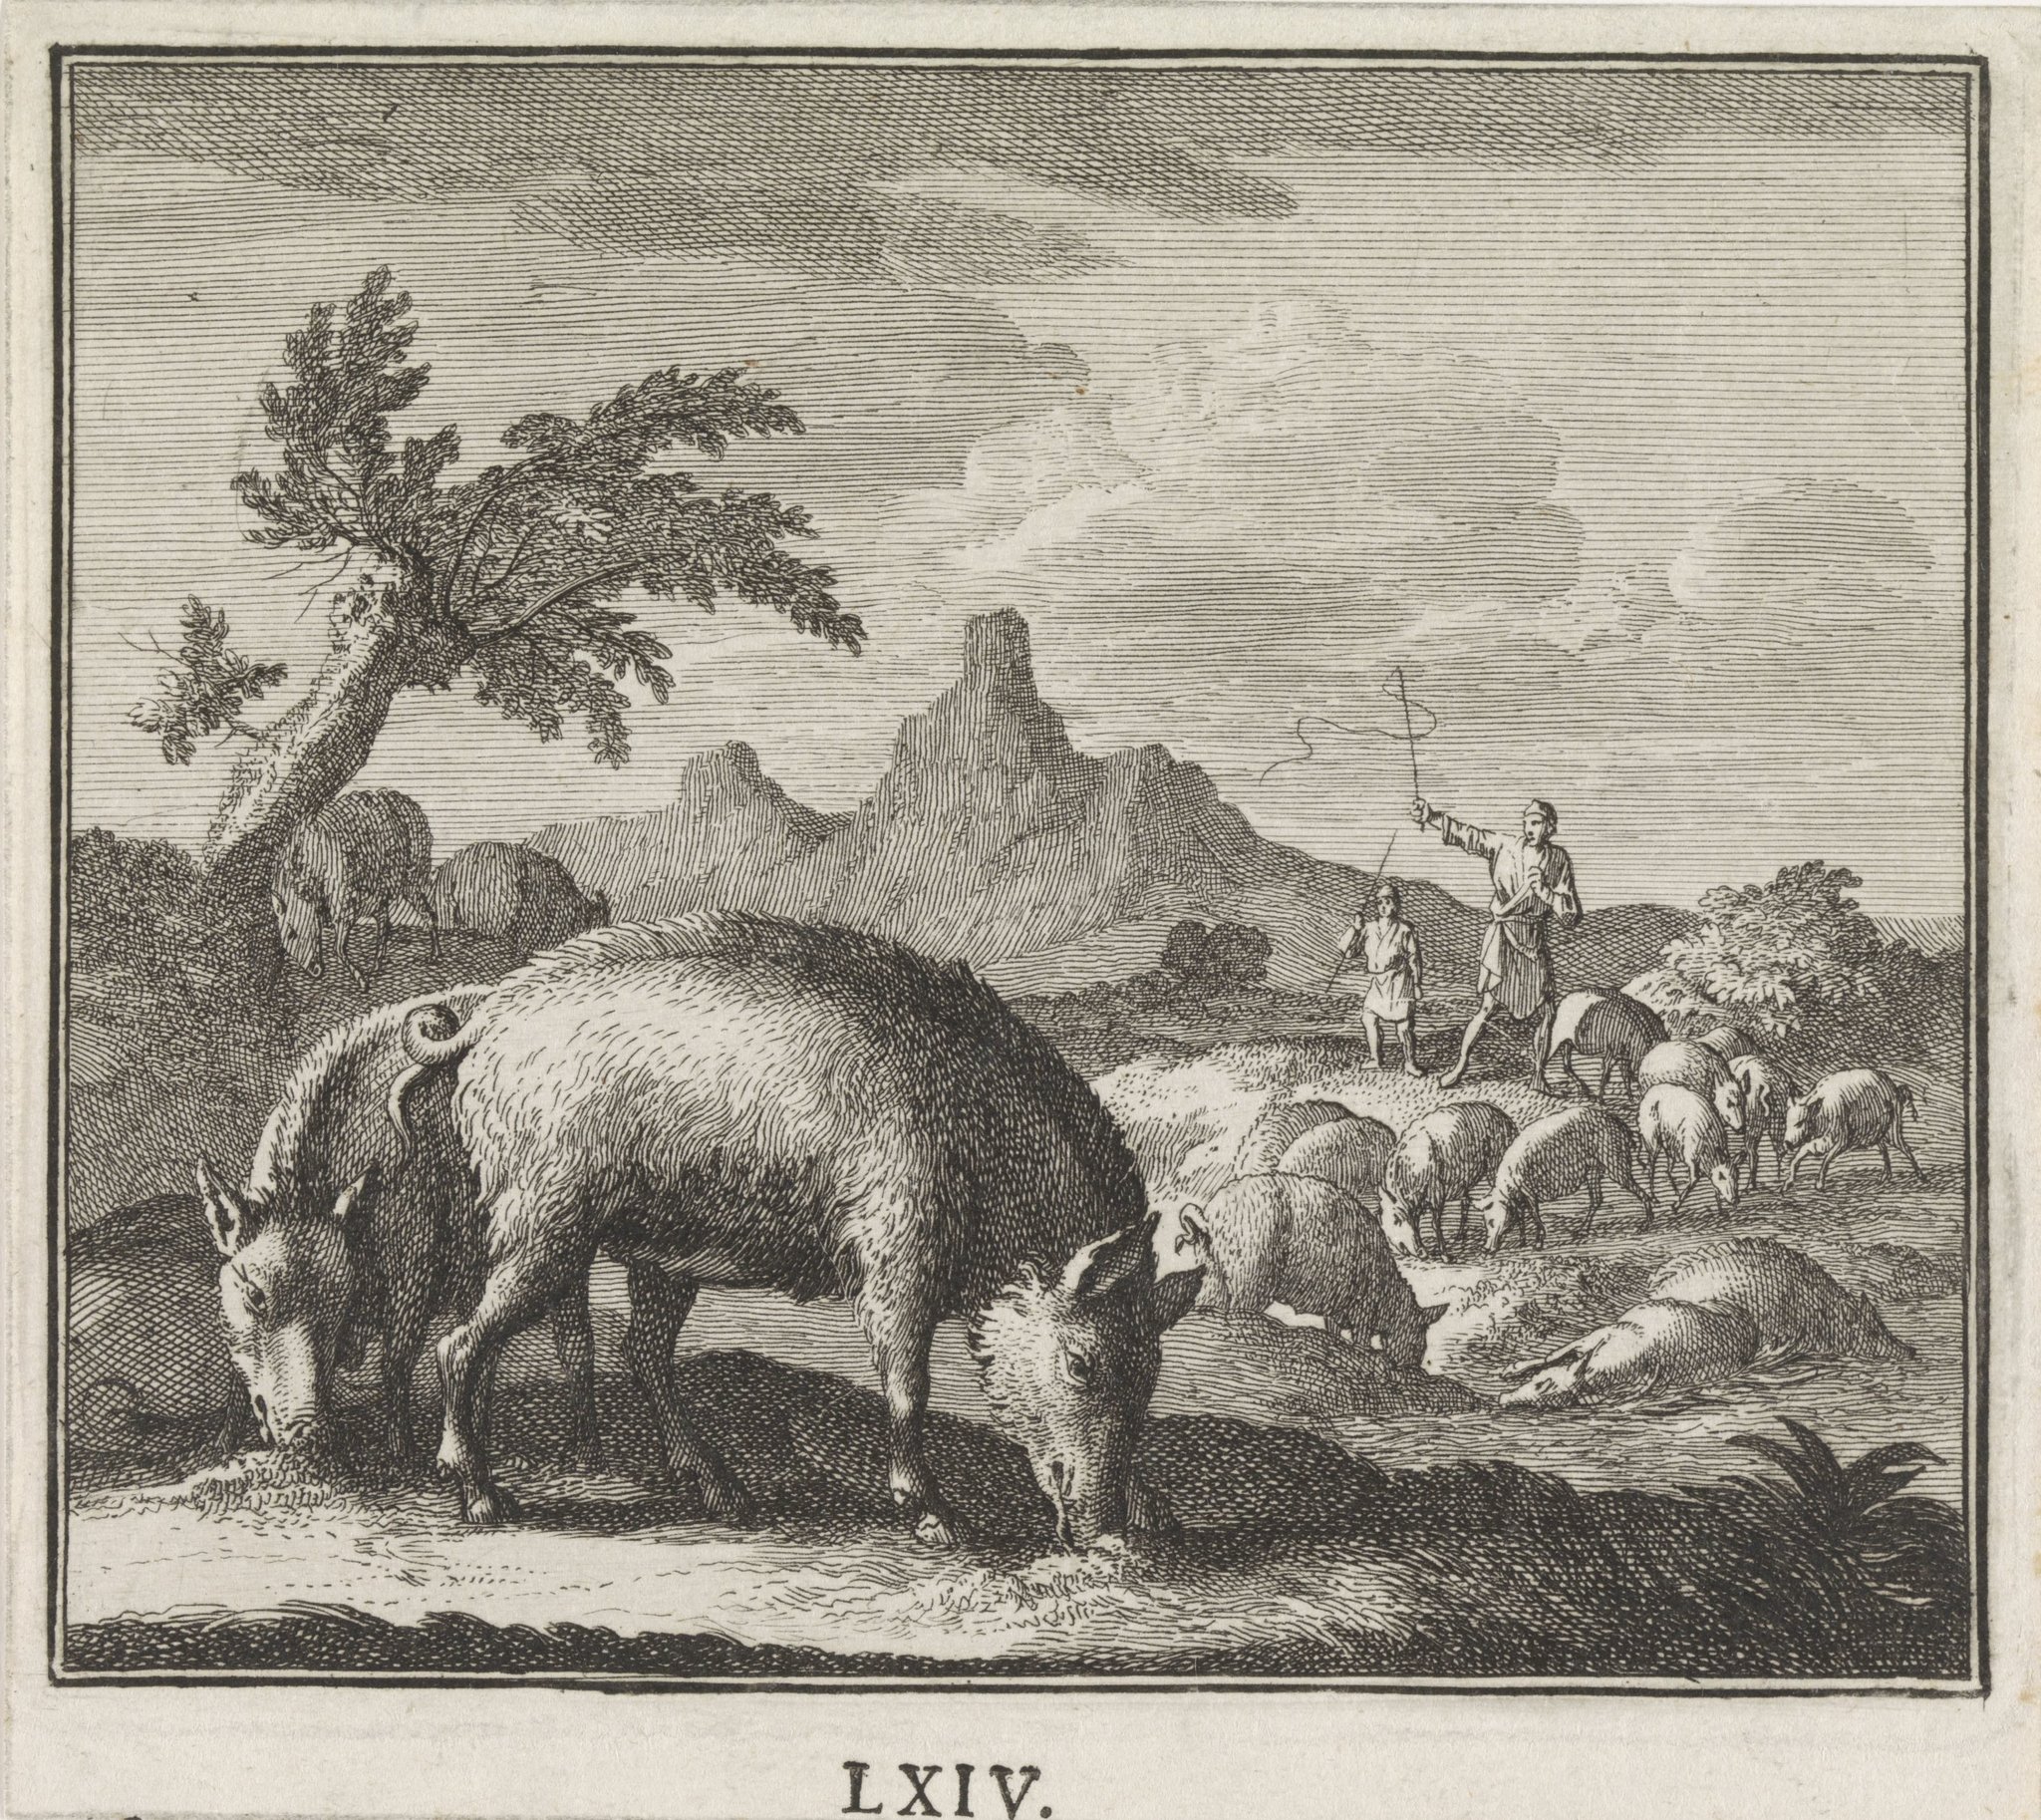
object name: book illustration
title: Twee varkens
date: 1695-1705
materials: paper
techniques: etching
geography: nuremberg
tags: pig, herding, herdsman, herdswoman, shepherd, shepherdess, cowherd, etc., abstract ideas and concepts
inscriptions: collector's mark: Lugt 2228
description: Boekillustratie voor Weigel, Christoph. Ethica Naturalis seu Documenta Moralia e Variis rerum Naturalium proprietatibus Virtutum Vitiorumq symbolicis imaginibus collecta. Neurenberg: Christoph Weigel: c. 1700.